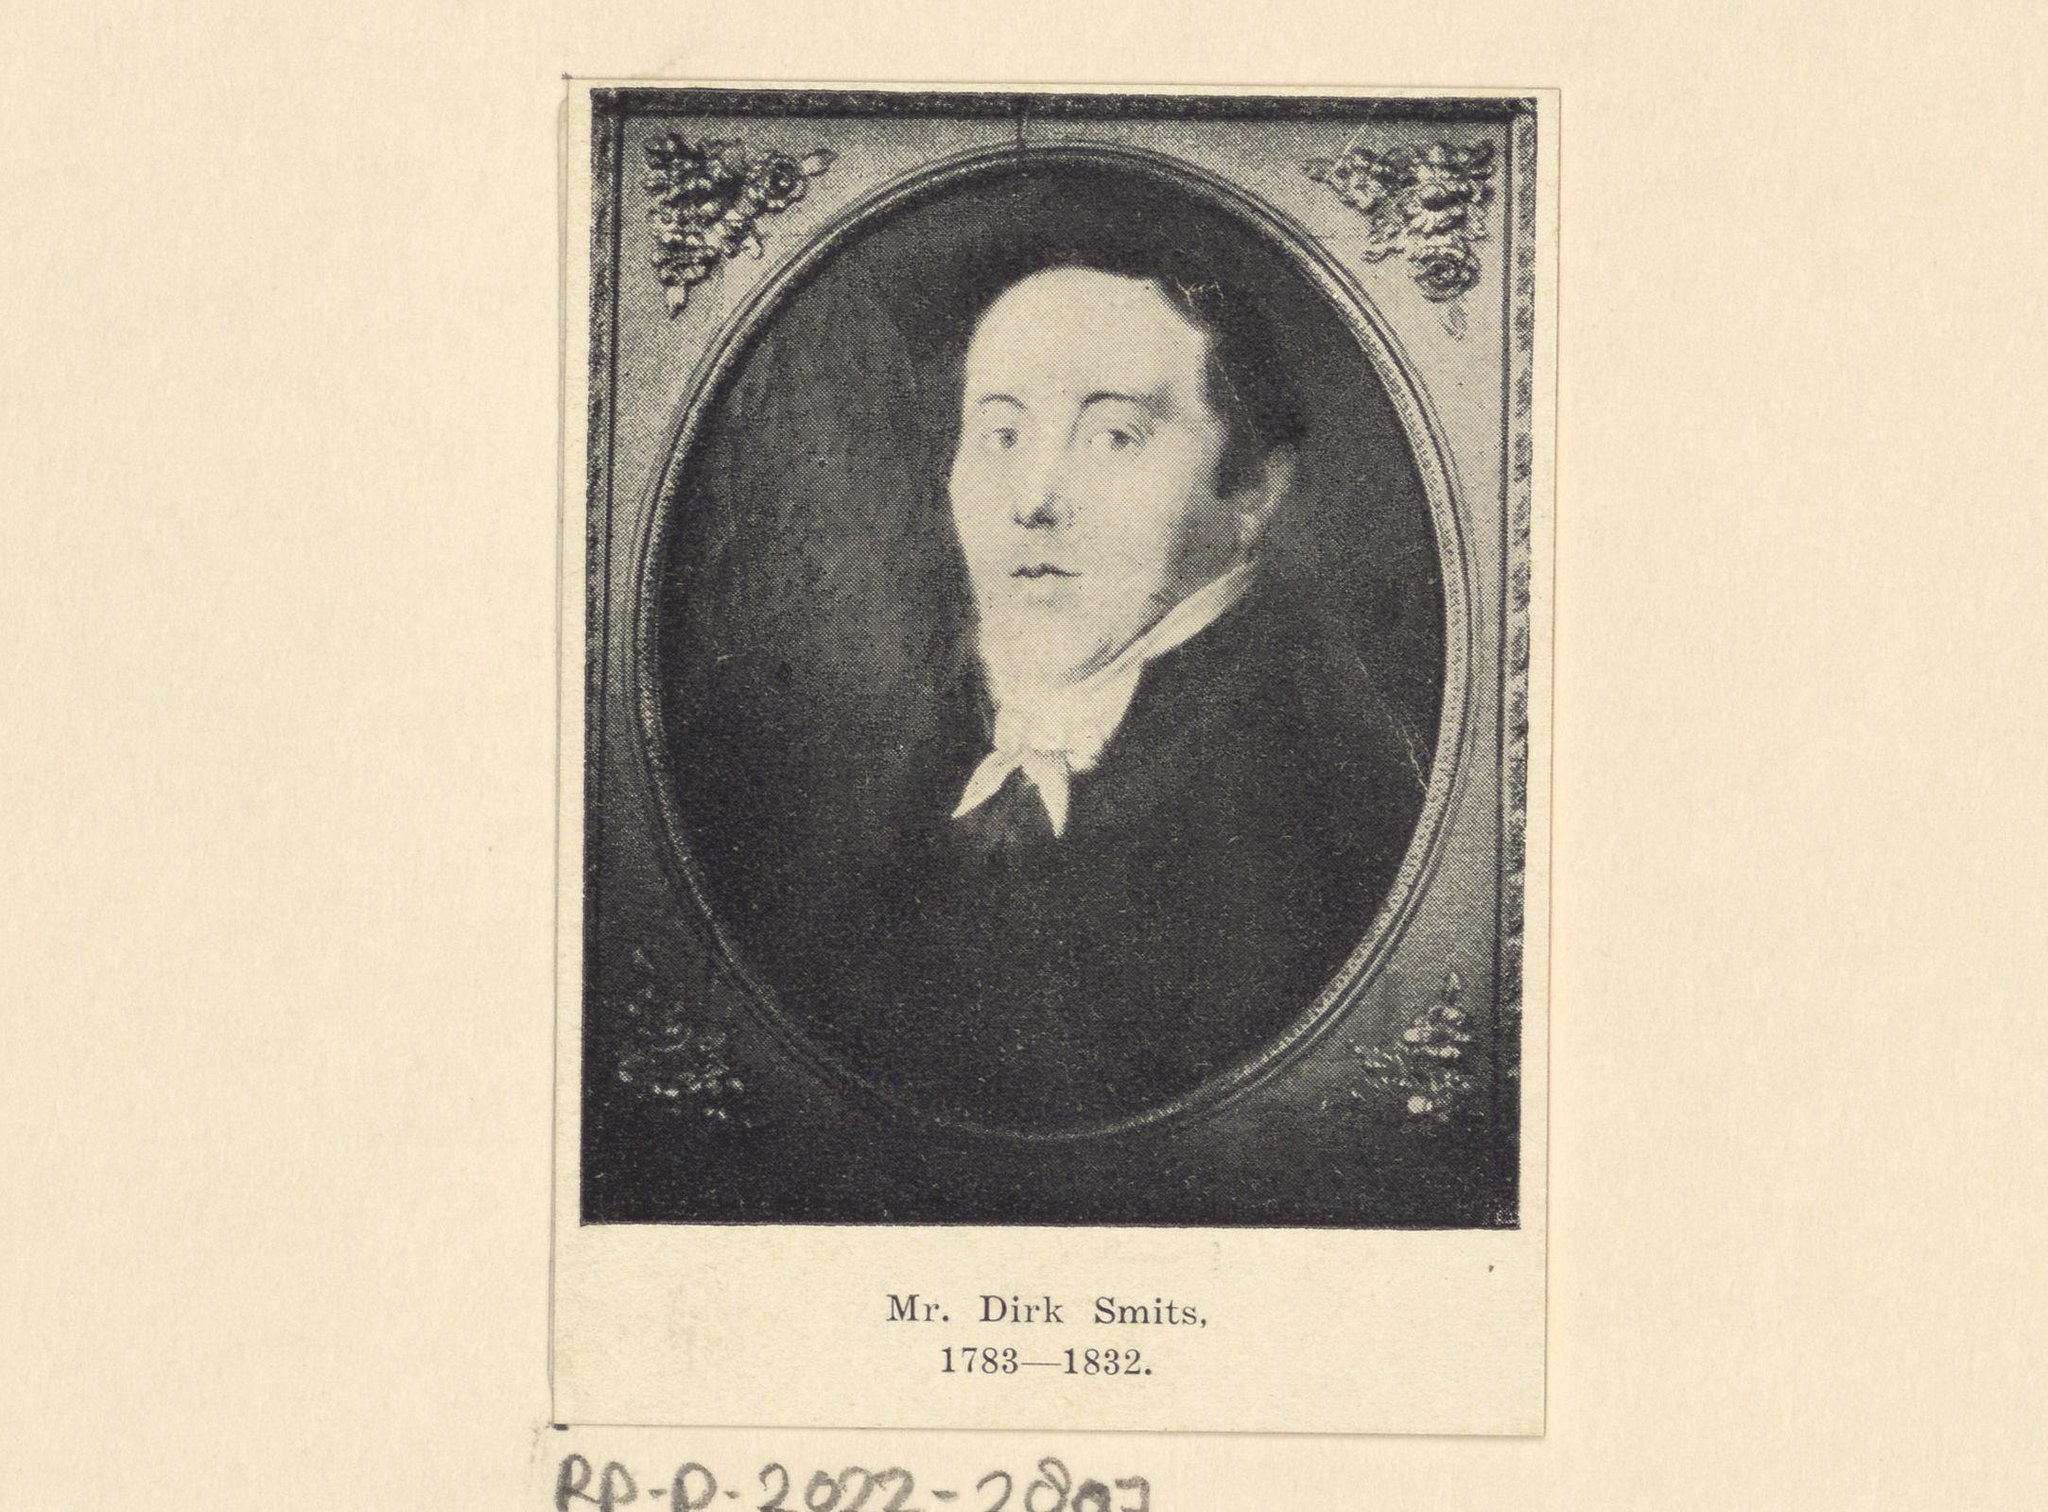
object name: photomechanical print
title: Portret van Dirk Smits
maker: Anonymous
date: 1882-1970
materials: paper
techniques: autotype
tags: rotterdam, hellevoetsluis, dirk smits, historical persons